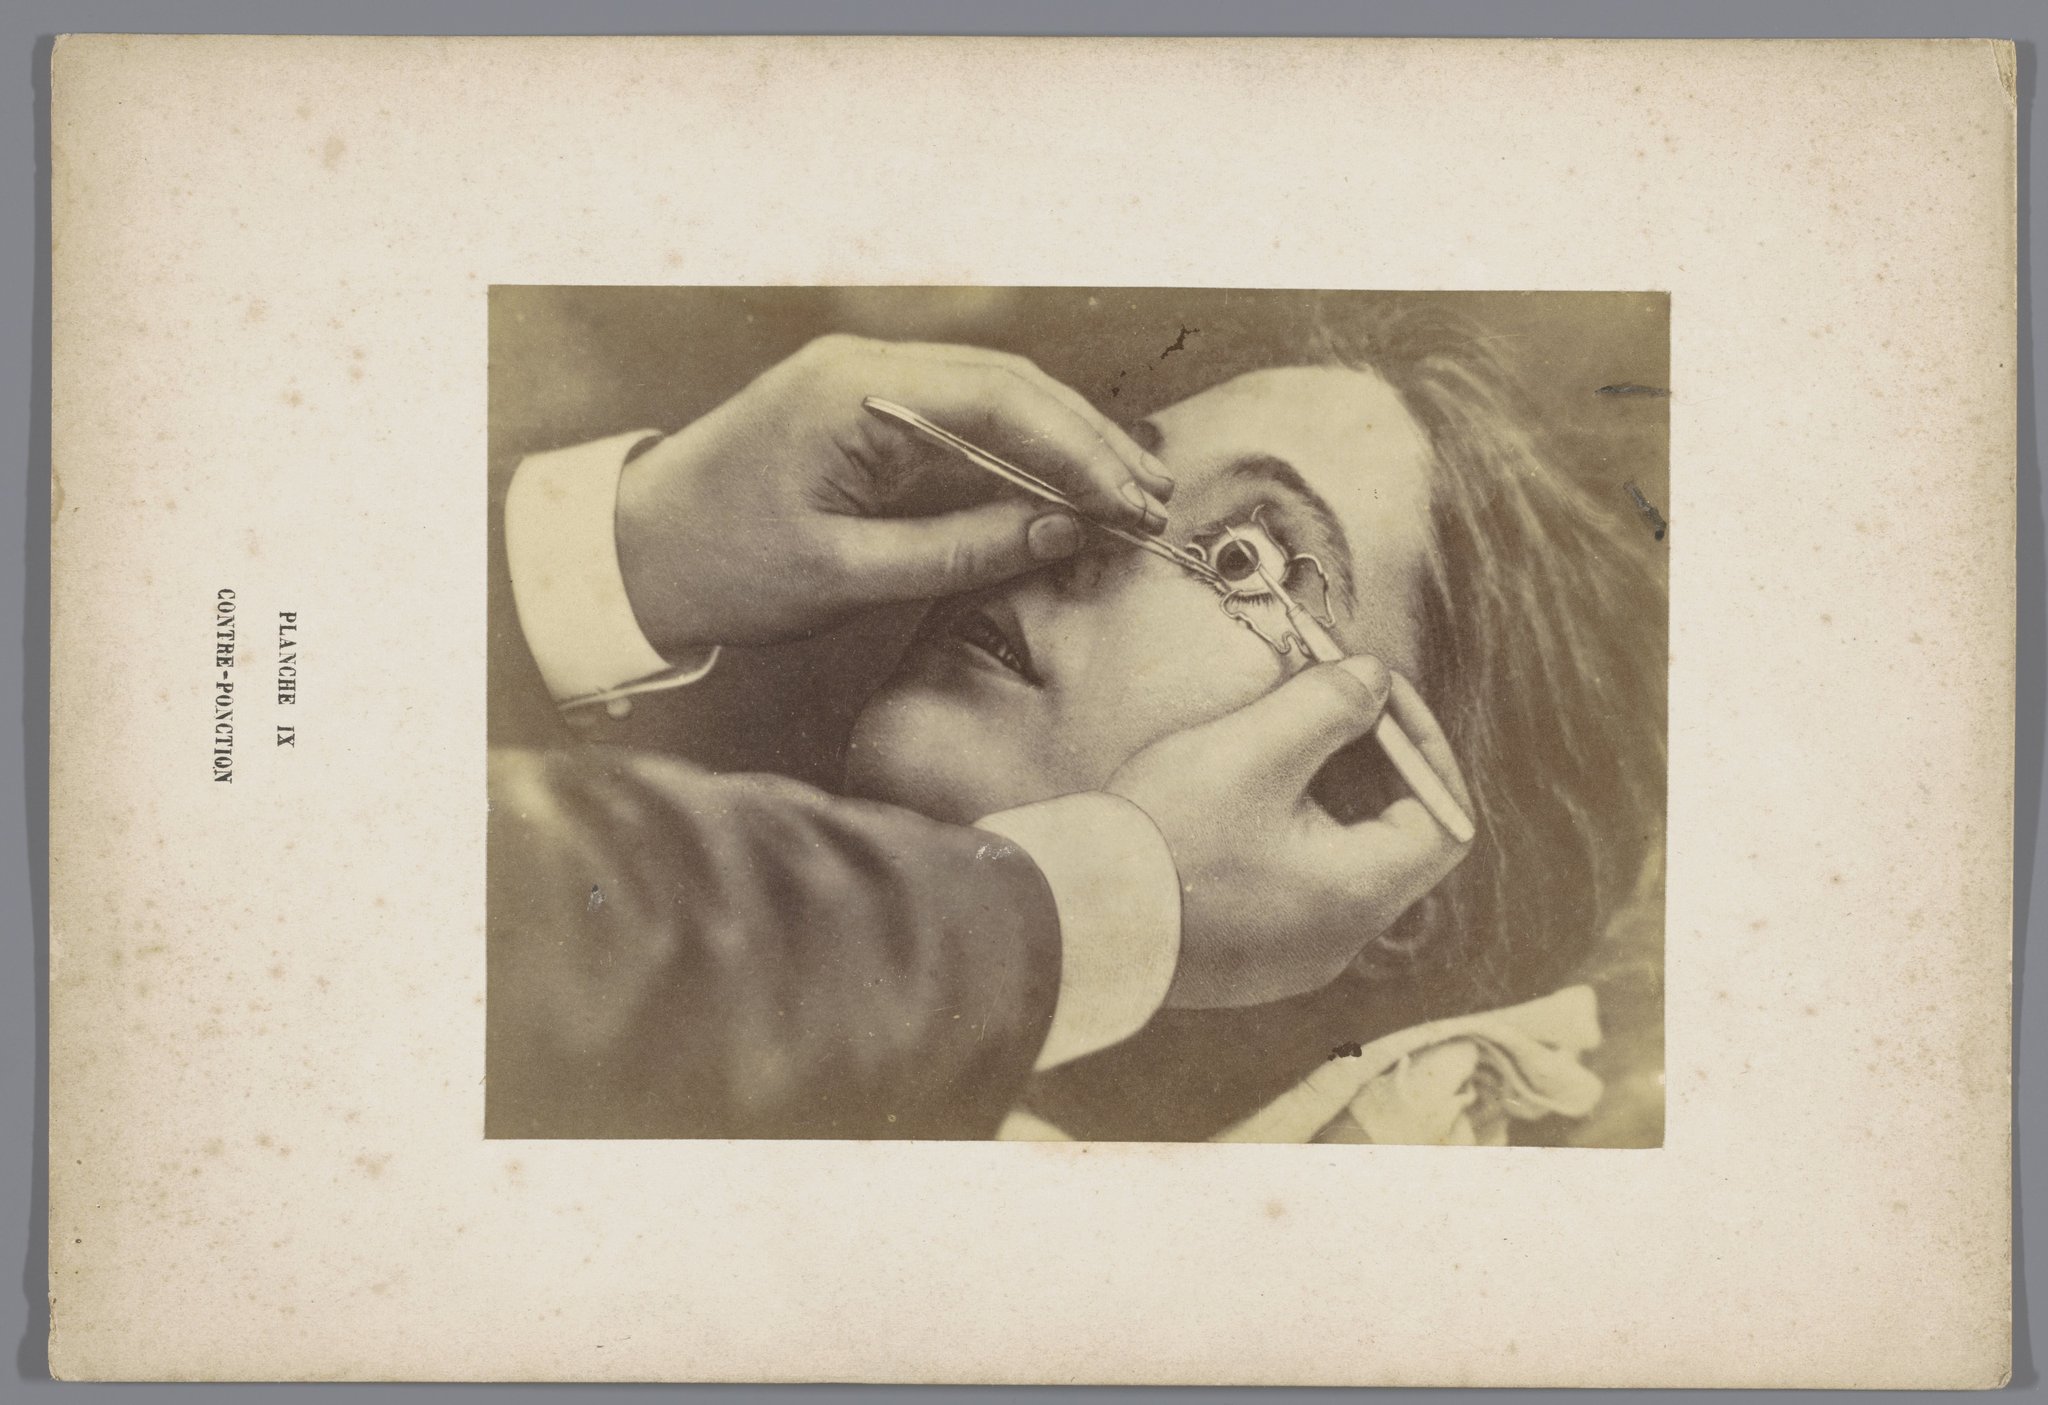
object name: photograph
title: Verwijderen van staar tijdens een oogoperatie door middel van een tegenpunctie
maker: a. de montméja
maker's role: arts, fotograaf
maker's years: 1841-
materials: photographic support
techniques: albumen print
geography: france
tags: cataract, eyes, operation, surgery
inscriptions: number: ‘Planche IX’